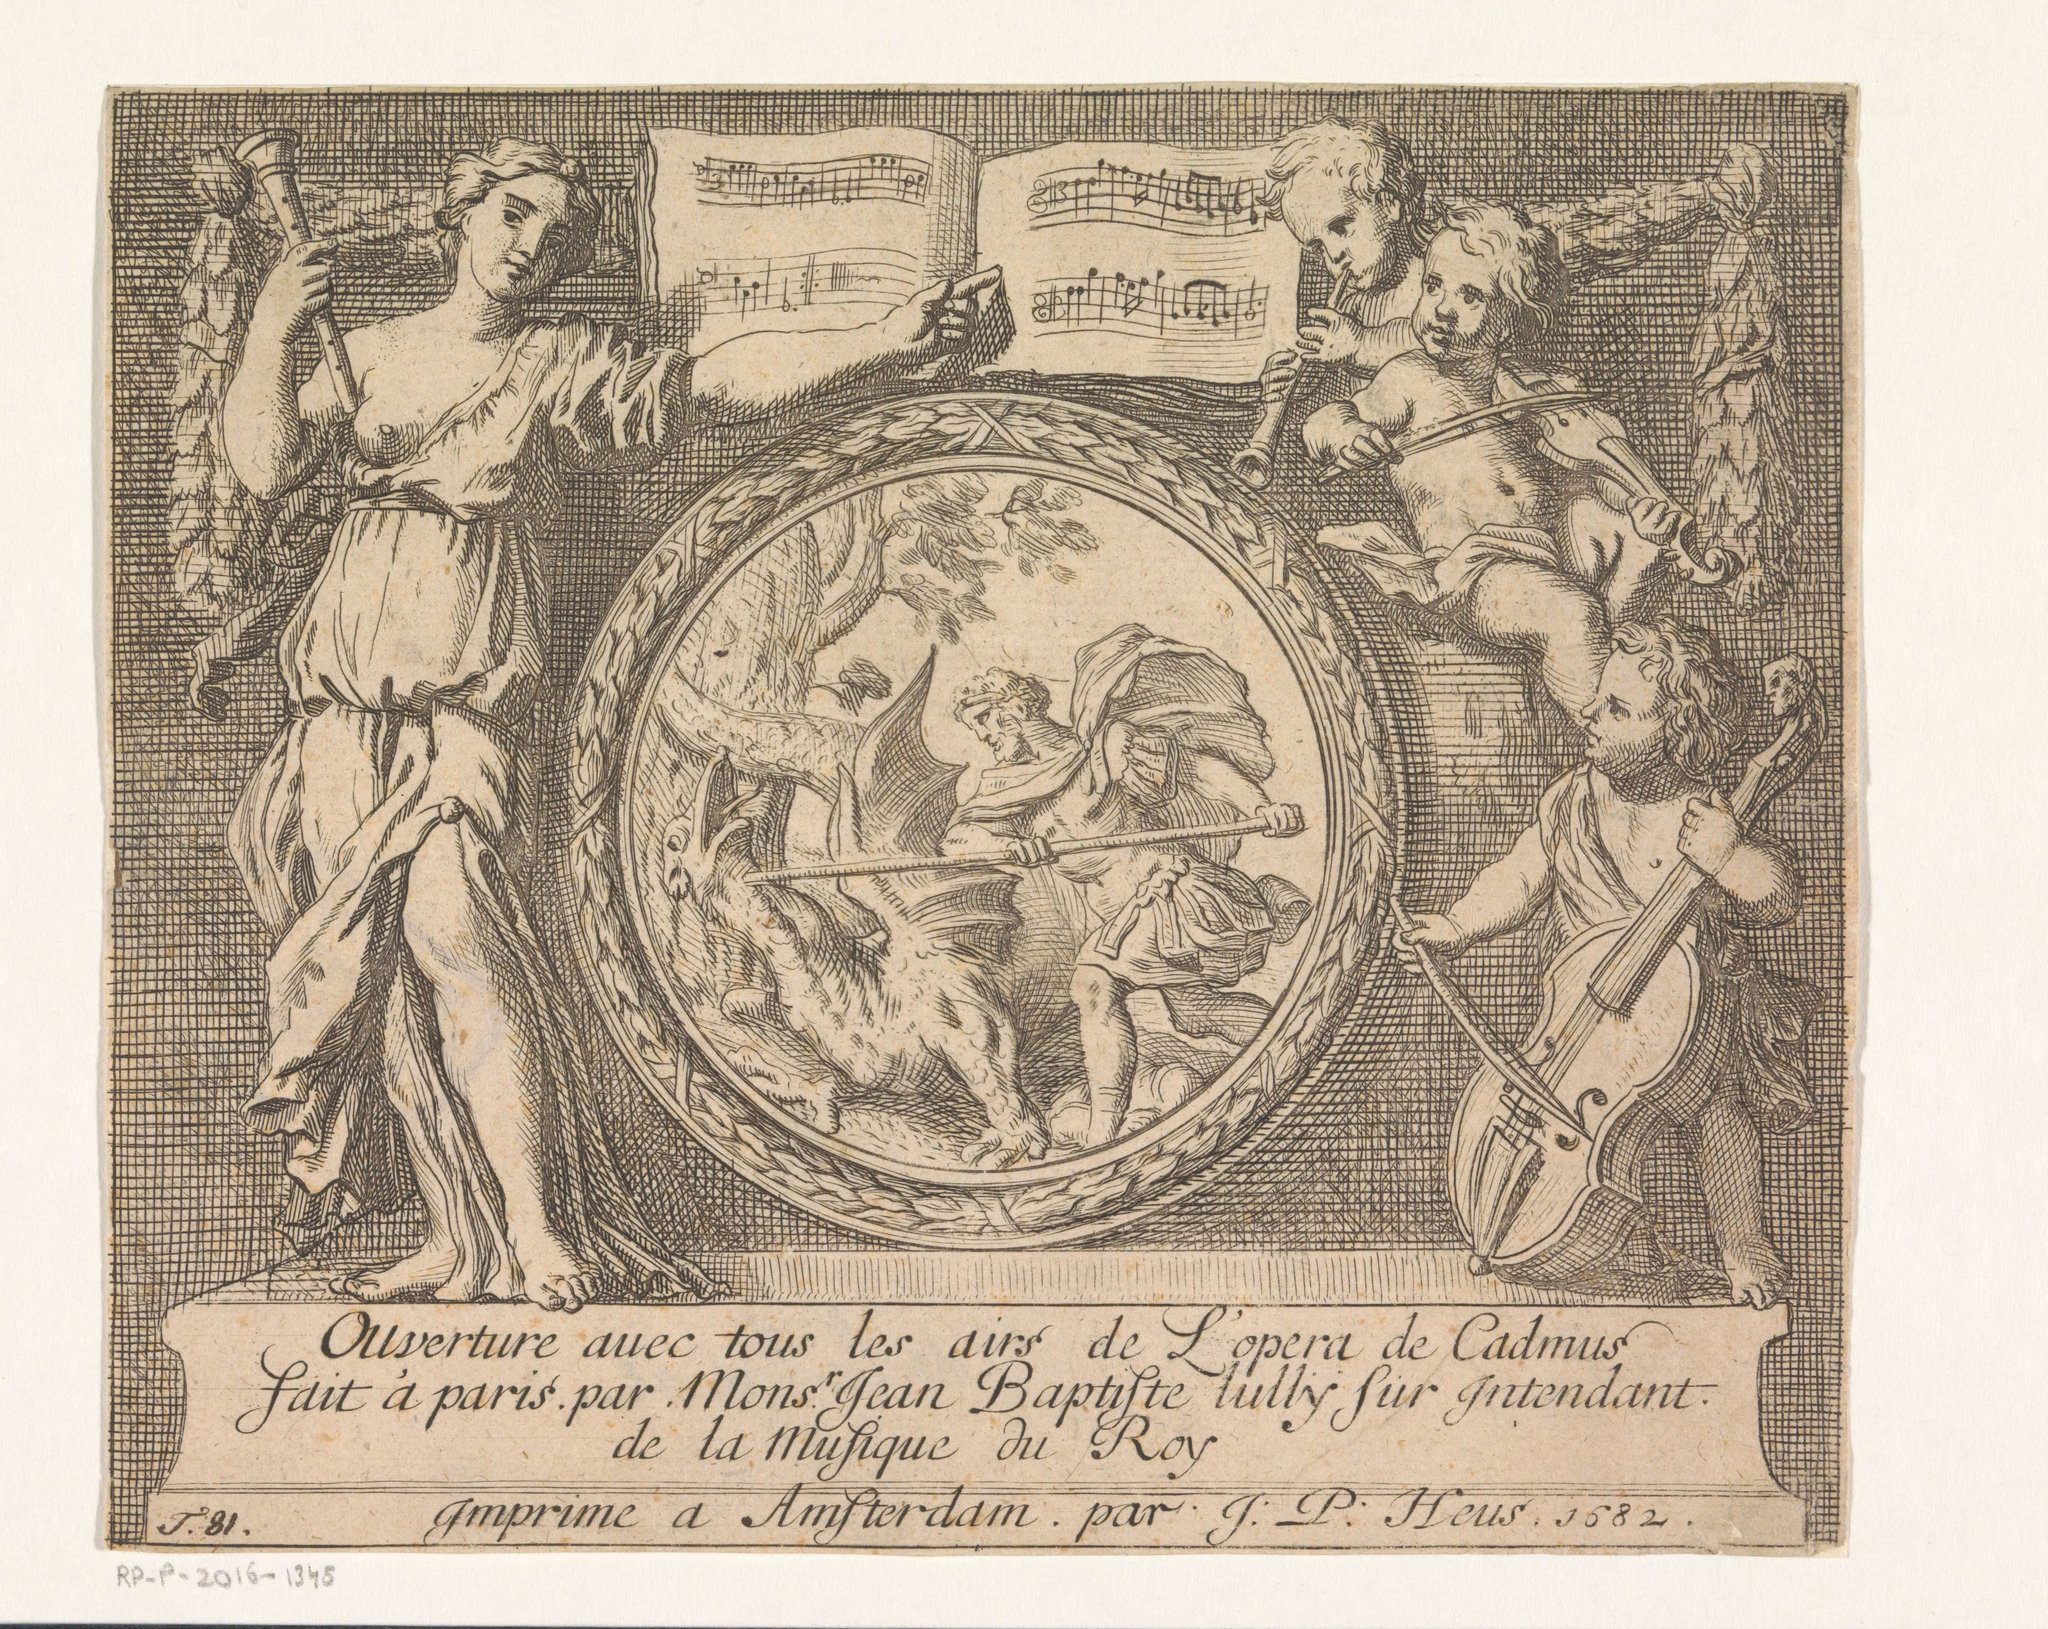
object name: print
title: Cadmus doodt de draak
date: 1682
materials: paper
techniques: etching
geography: amsterdam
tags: musical instruments; group of musical instruments, cupids: 'amores', 'amoretti', 'putti', cadmus slays the dragon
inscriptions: number: ‘T.81’, collector's mark: Lugt 11, collector's mark: ‘Hinloopen’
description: Cadmus doodt de draak die zijn metgezellen verslonden heeft. De mythologische voorstelling is gevat in een medaillonvormige lijst. Links hiervan wijst een vrouw met een fluit op bladmuziek boven de lijst. Rechts bespelen drie putti verschillende instrumenten. Onderin de prent staat een drieregelig onderschrift in het Frans.